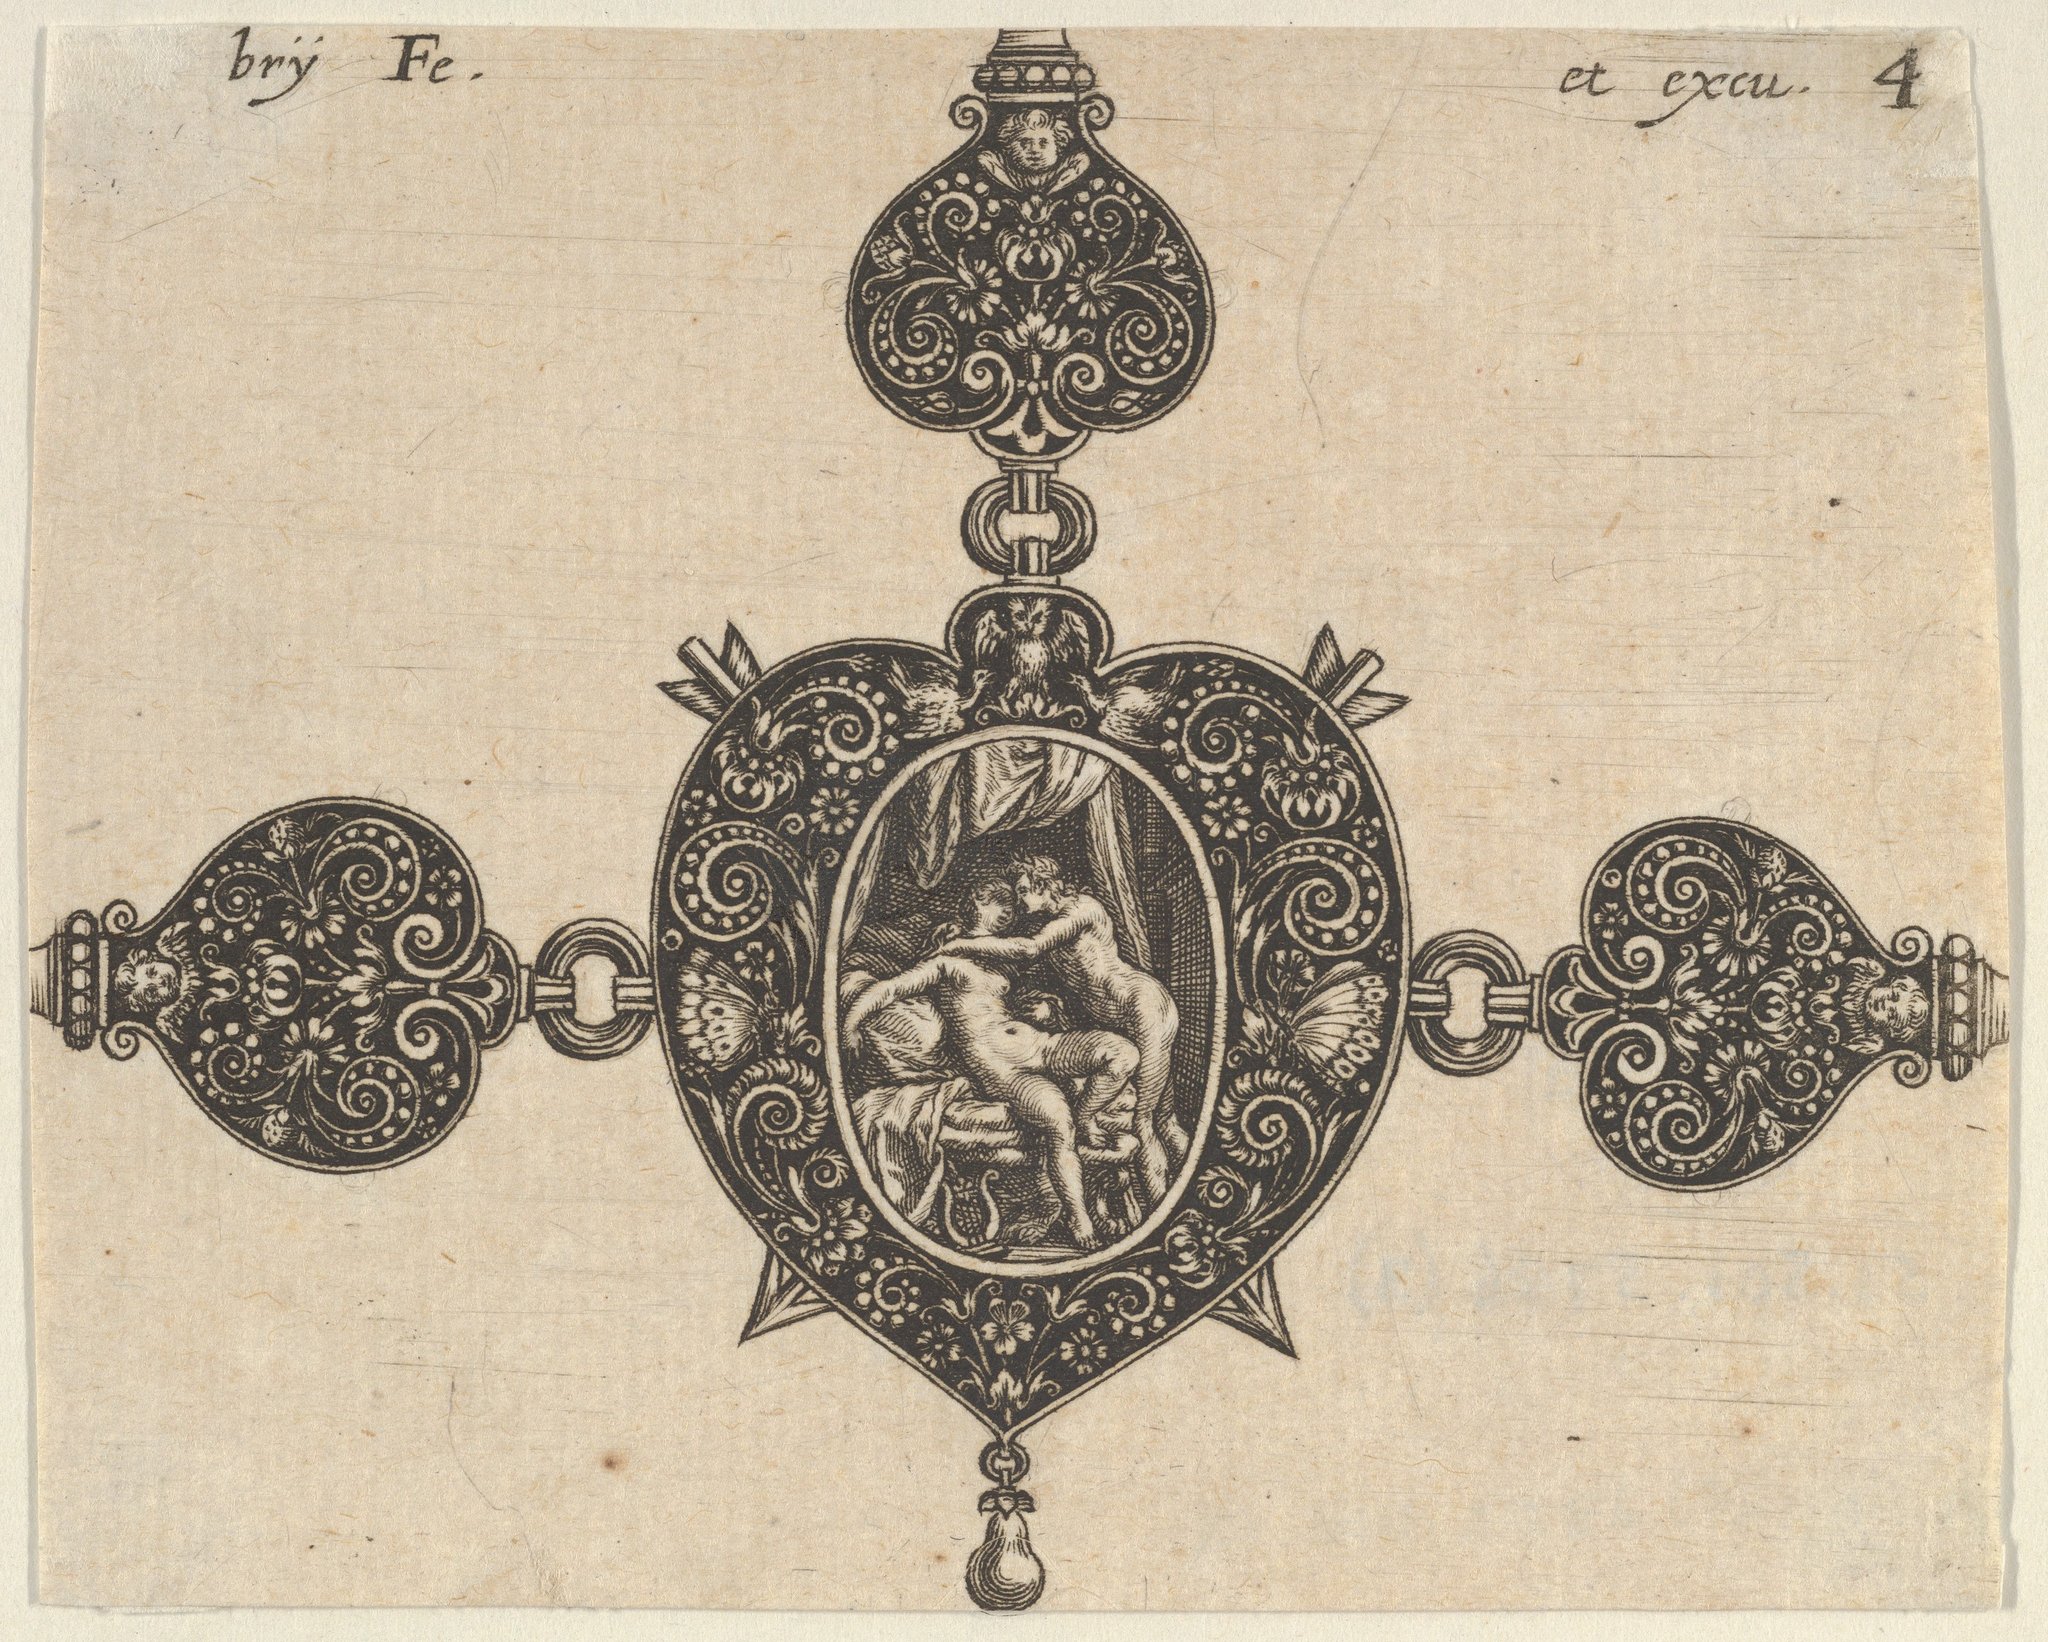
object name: print ornament architecture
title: Design for a Heart-Shaped Brooch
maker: johann theodor de bry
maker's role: artist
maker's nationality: netherlandish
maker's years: 1561-1623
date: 1580-1600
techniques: embroidery, engraving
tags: jewelry,brooches,male nudes,female nudes